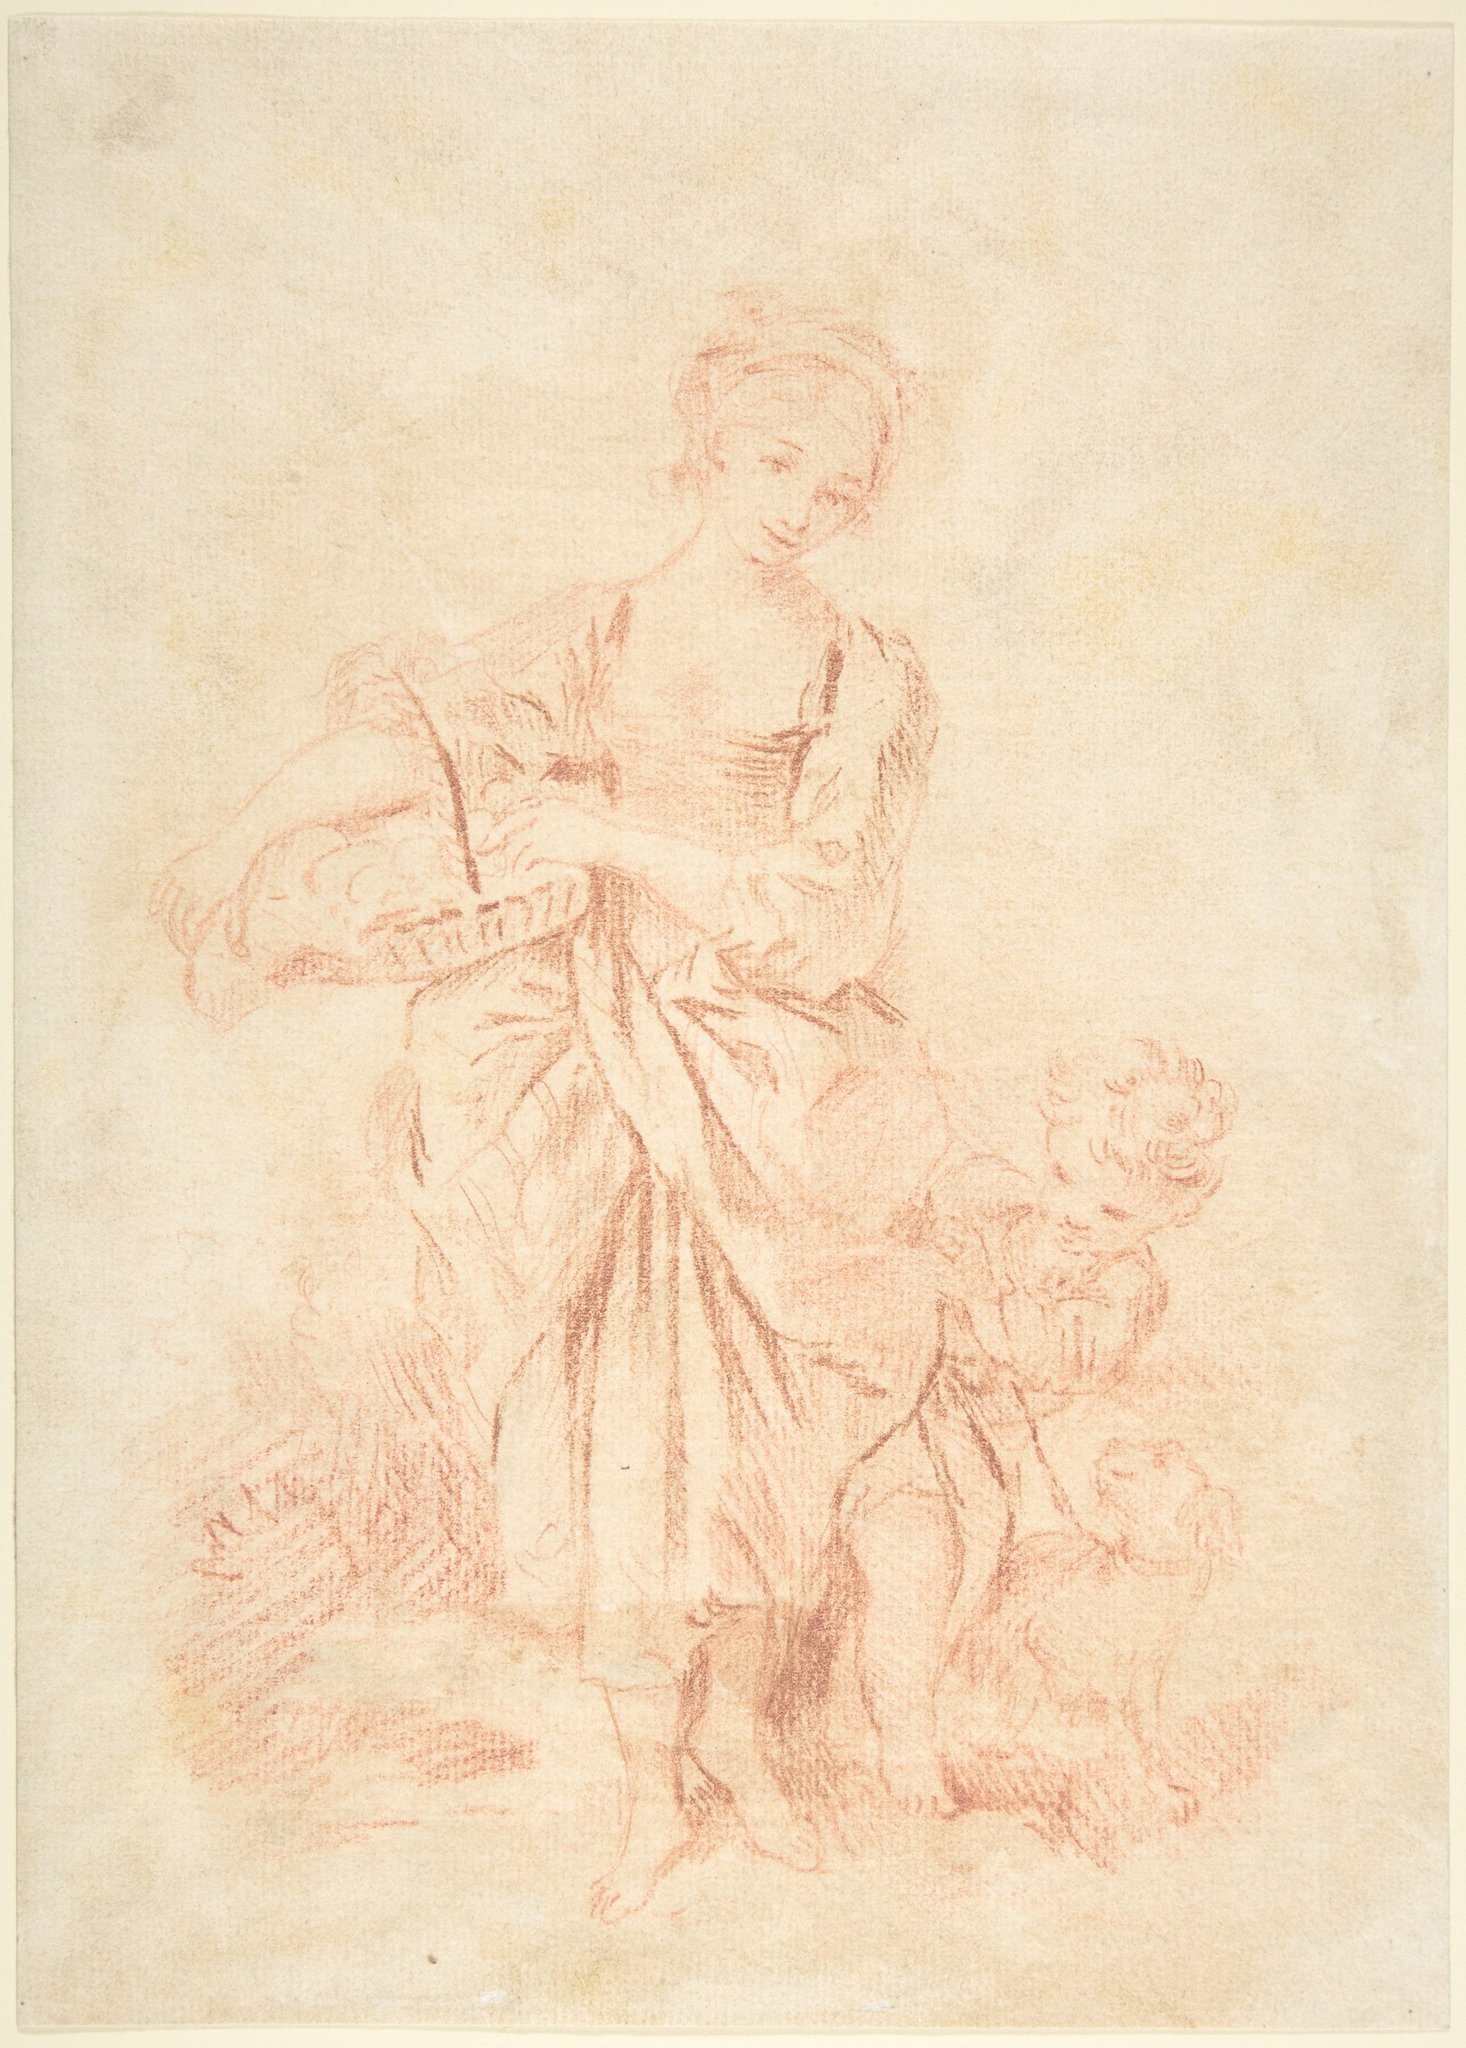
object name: drawing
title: Young Girl with a Boy and a Dog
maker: françois boucher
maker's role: artist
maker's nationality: french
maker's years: 1703-1770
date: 1701-1800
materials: chalk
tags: boys,girls,dogs